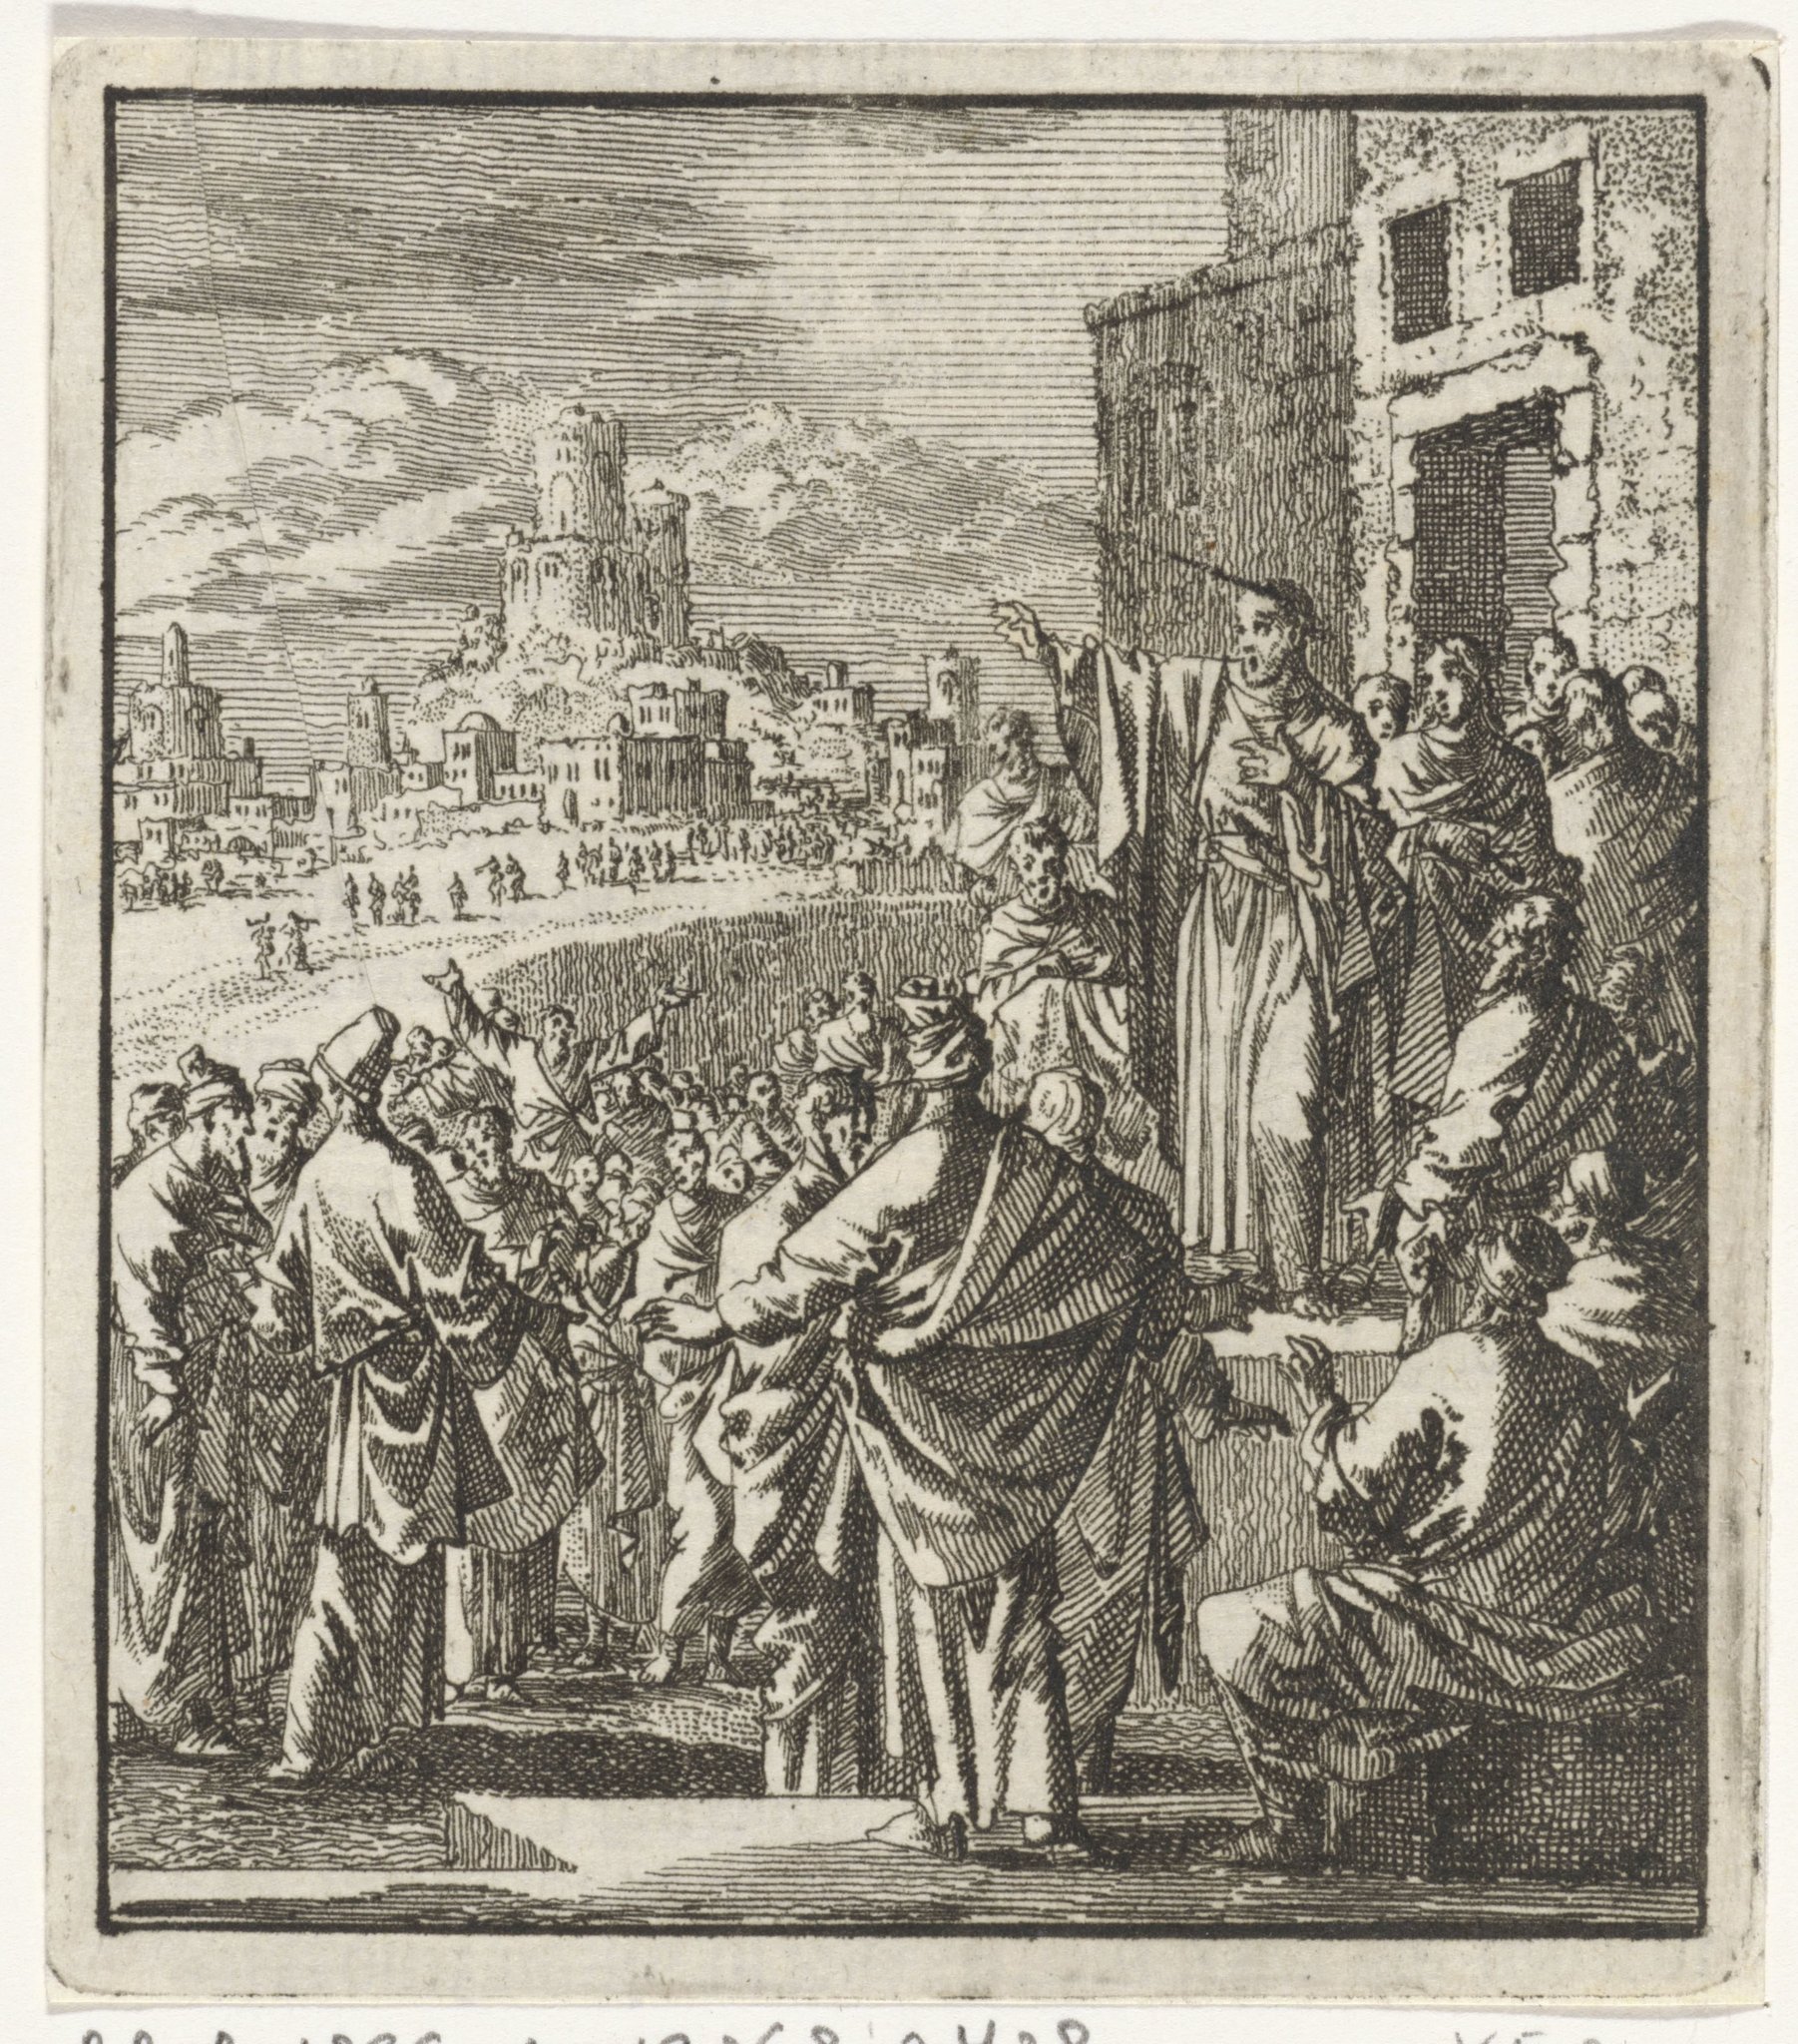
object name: print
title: Petrus predikt op stoep van een woning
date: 1706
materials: paper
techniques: etching, letterpress printing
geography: amsterdam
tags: life and acts of peter, preaching (in general)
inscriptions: collector's mark: Lugt 2228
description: Illustratie voor: Schabaalje, Jean Philipsz. De vermeerderde lust-hof des gemoeds. Amsterdam: Jan Rieuwertsz. (II) en Barent Visscher, 1706, p. 423.